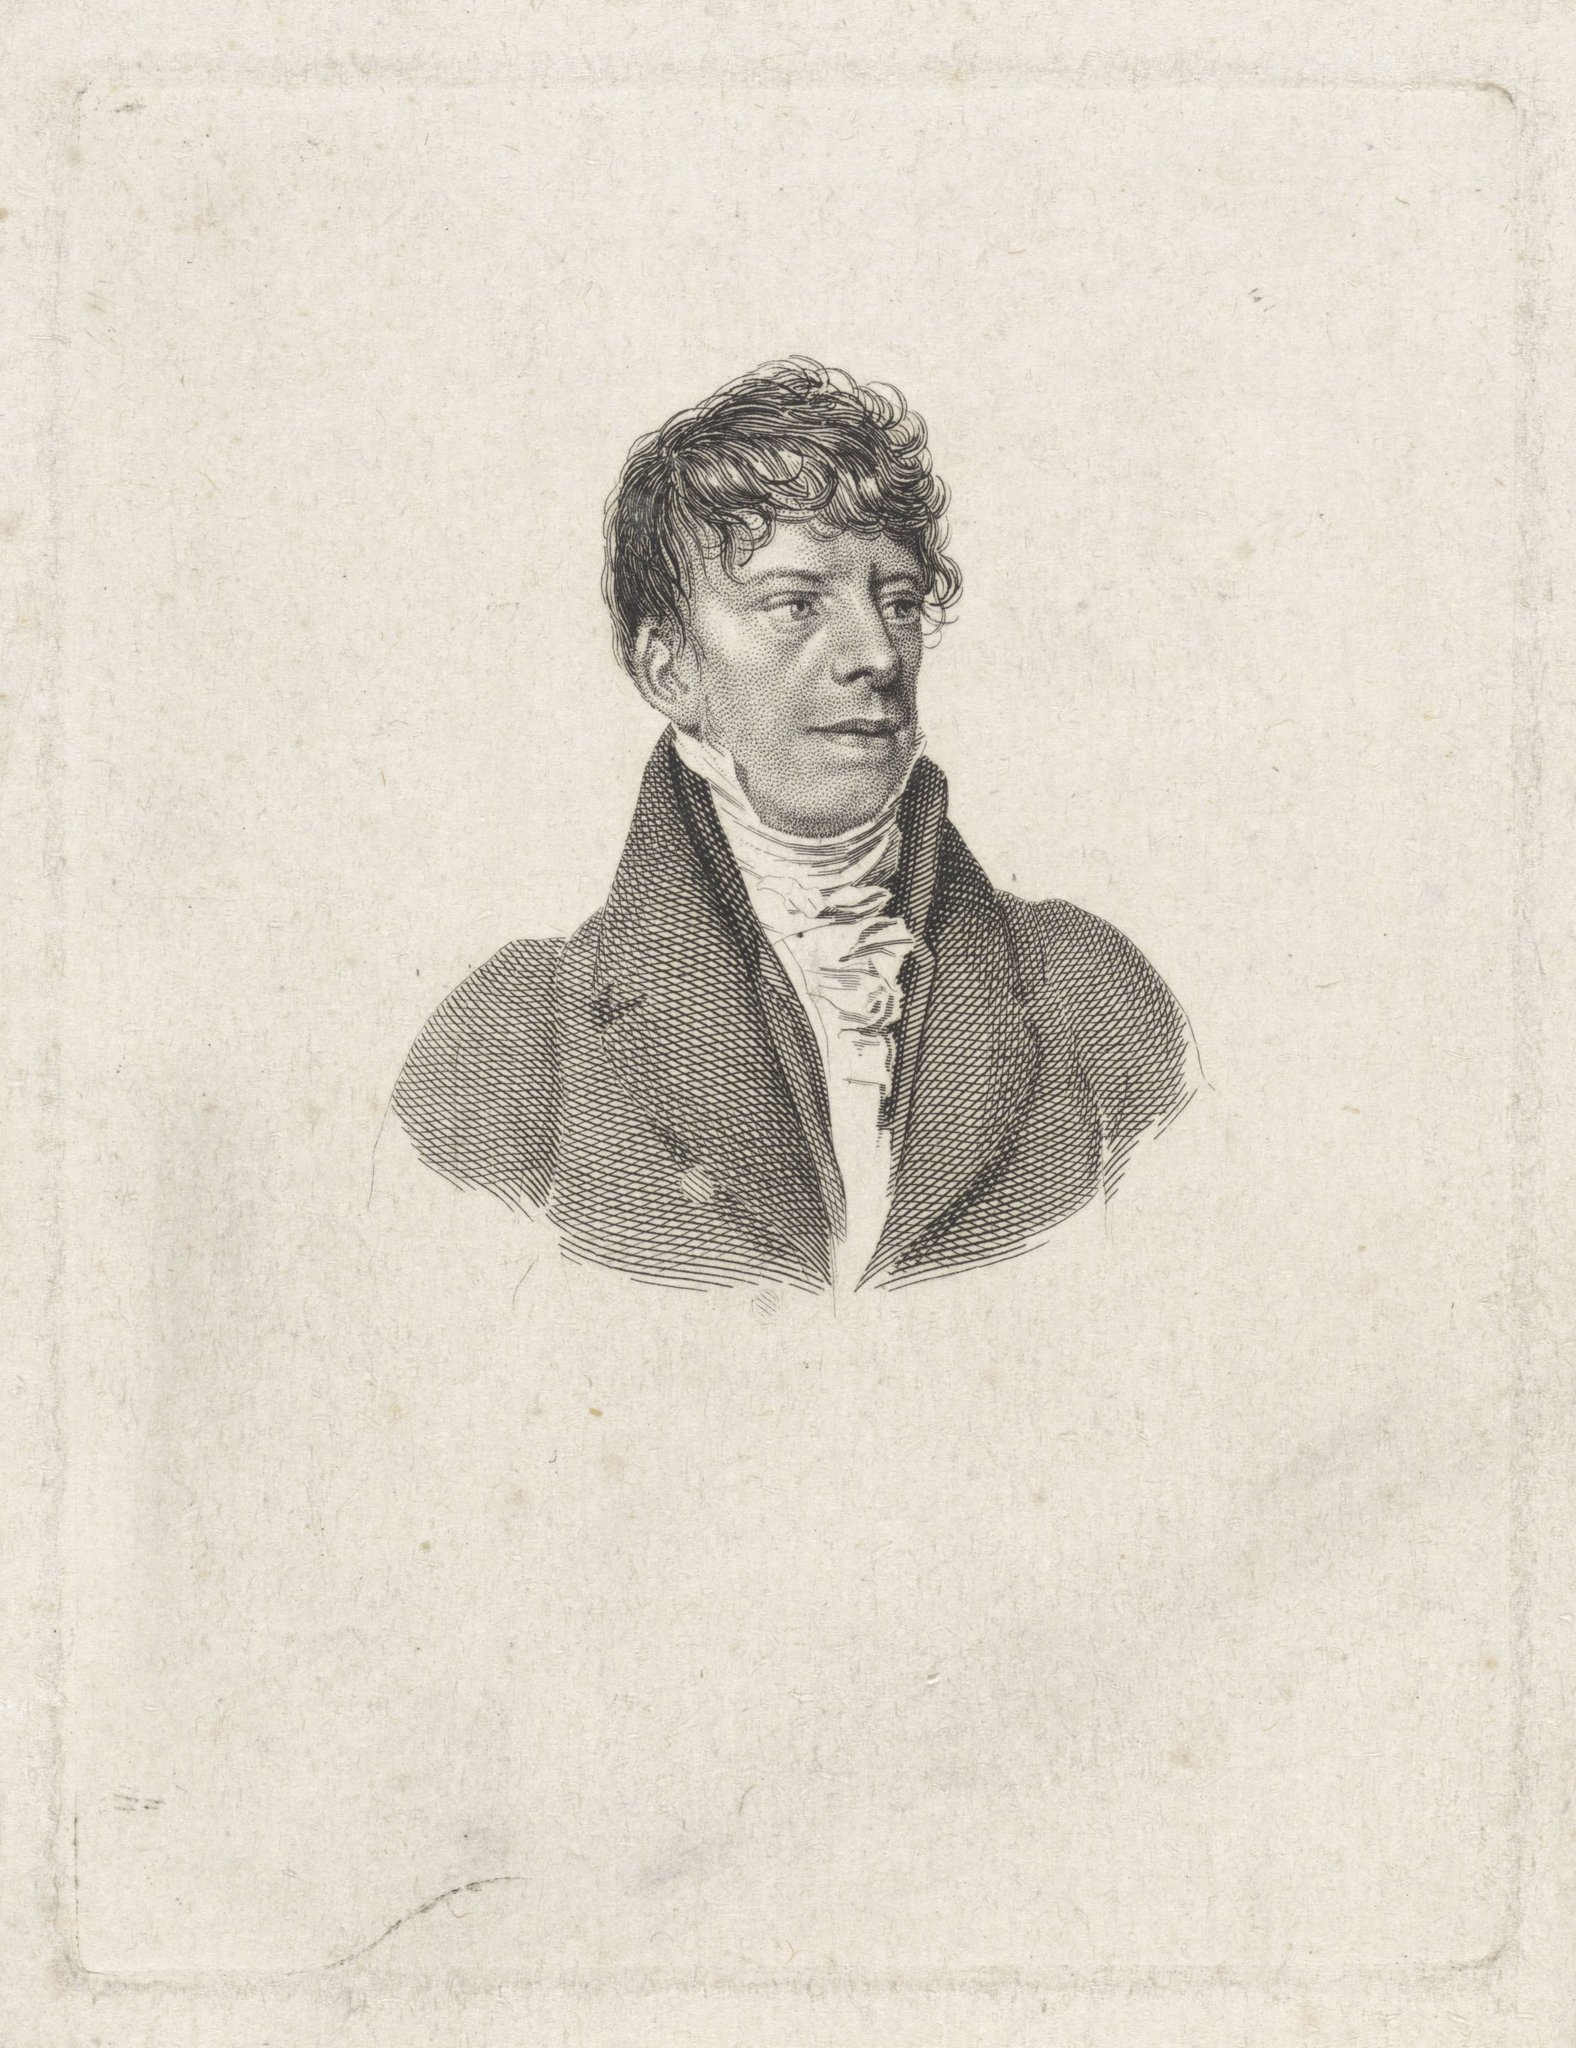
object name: print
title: Portret van Jan Hulswit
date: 1797-1836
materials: paper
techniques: engraving, etching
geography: netherlands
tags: amsterdam, painter, draughtsman, jan hulswit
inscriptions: collector's mark: Lugt 2228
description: Portret van de Amsterdamse kunstschilder Jan Hulswit.